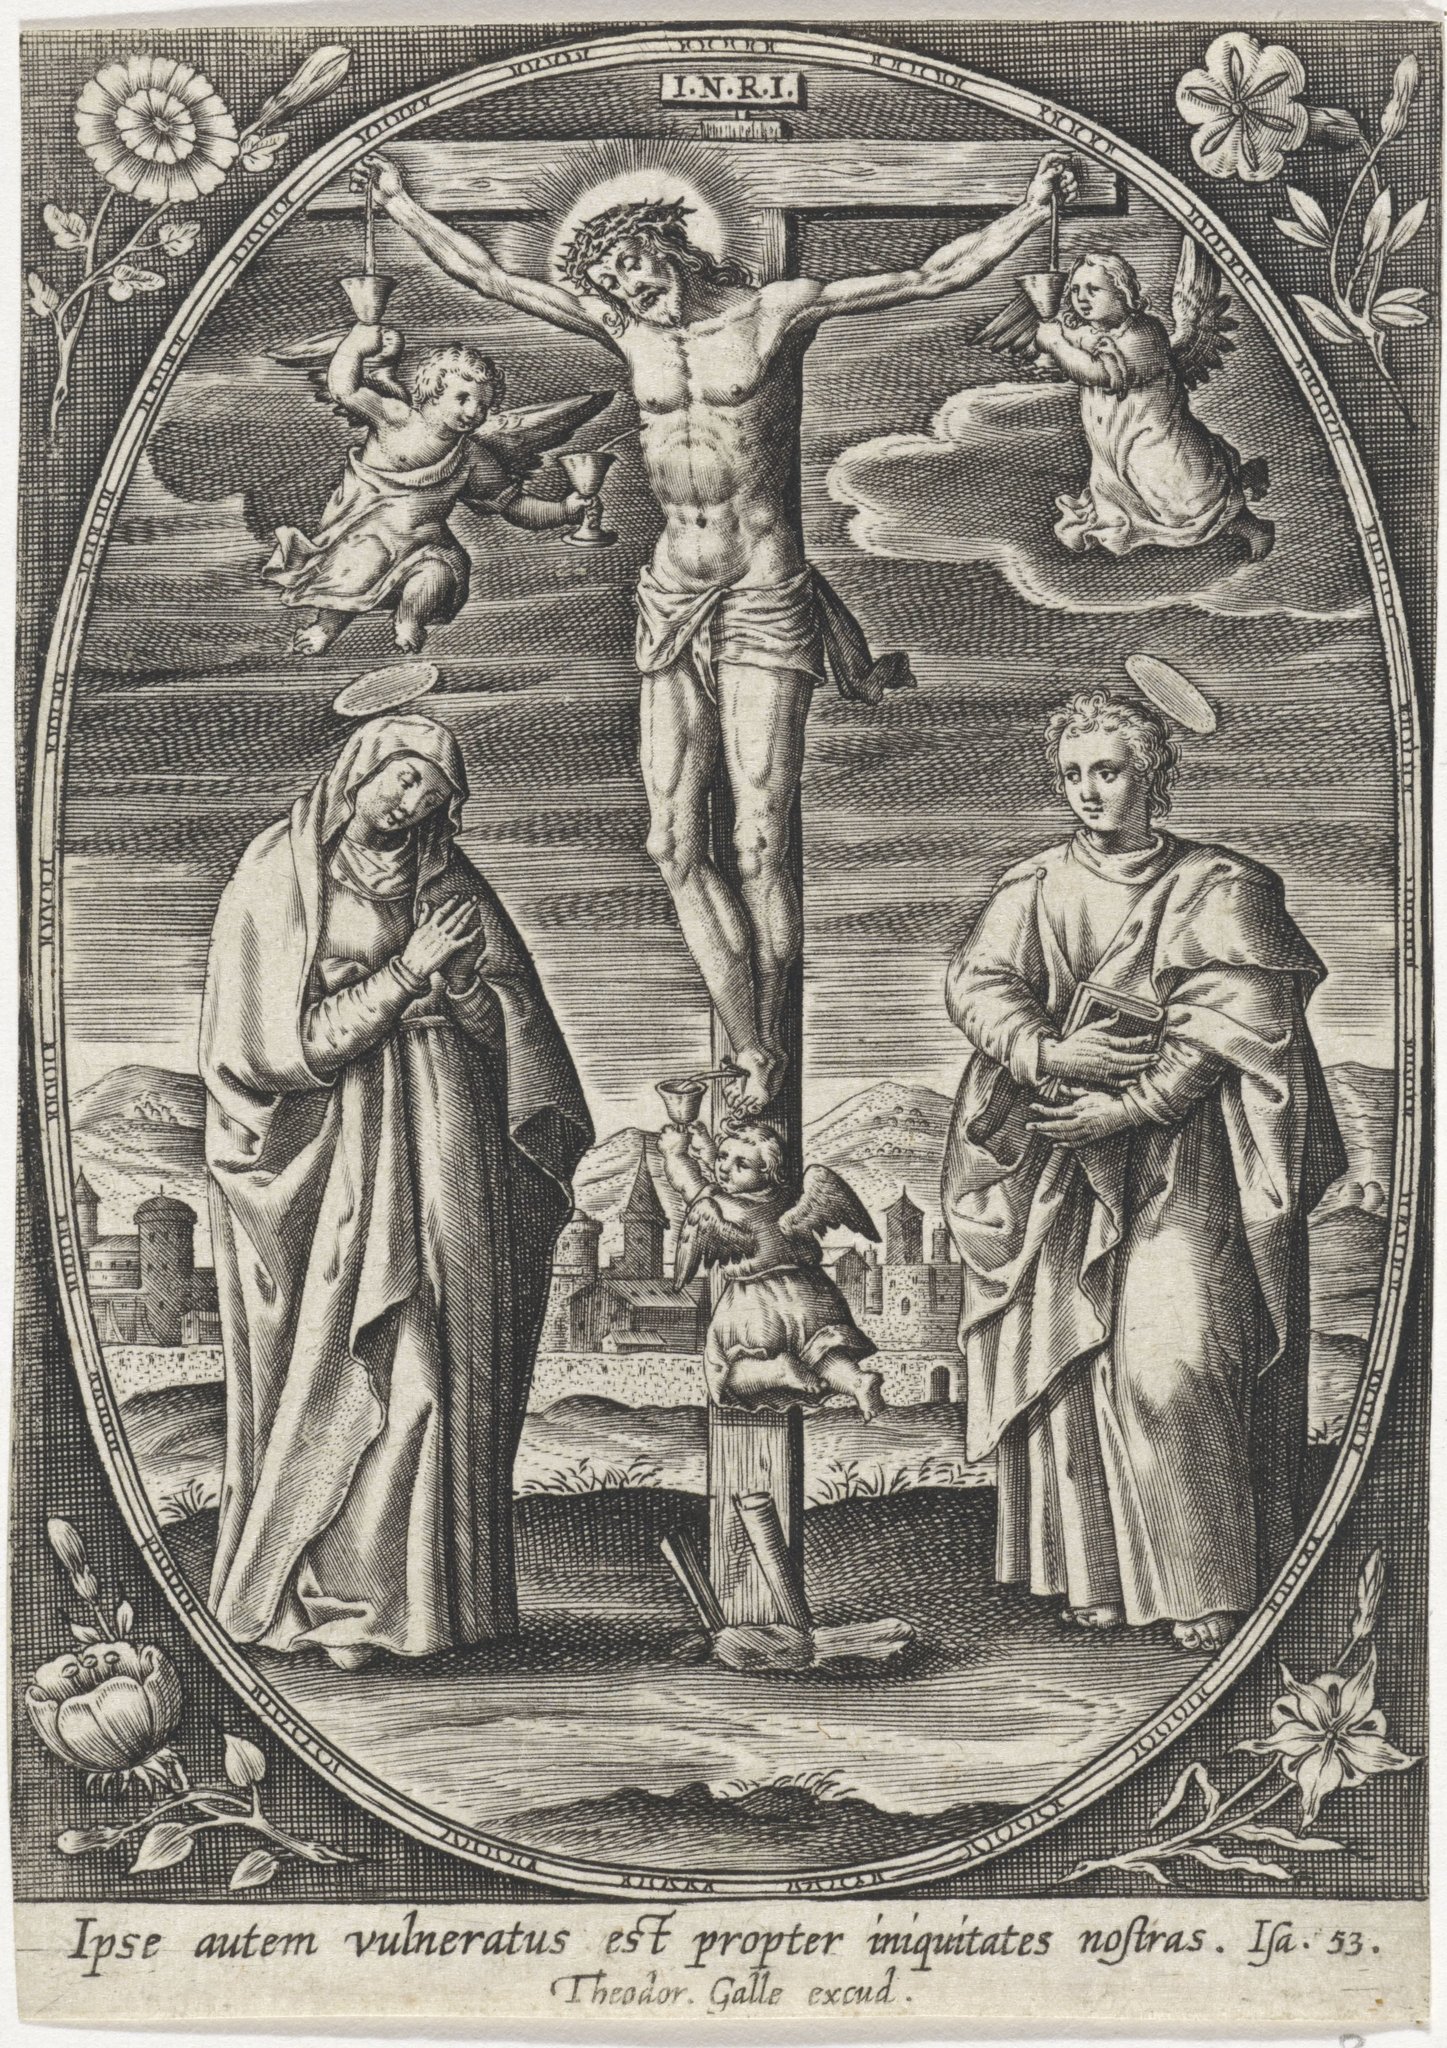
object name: print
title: Kruisiging van Christus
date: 1595-1633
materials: paper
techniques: engraving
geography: antwerp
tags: crucified christ, with particular persons under the cross, angel(s) catching christ's blood in cup(s)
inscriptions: collector's mark: Lugt 240, number: ‘38 - 22.’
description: Christus hangt aan het kruis. Aan de voet van het kruis Maria en Johannes. Engelen vangen het bloed uit de wonden van Christus op in hun kelk. In de hoeken van de omlijsting bloemen. In de marge een Bijbelcitaat uit Jes. 53 in het Latijn.